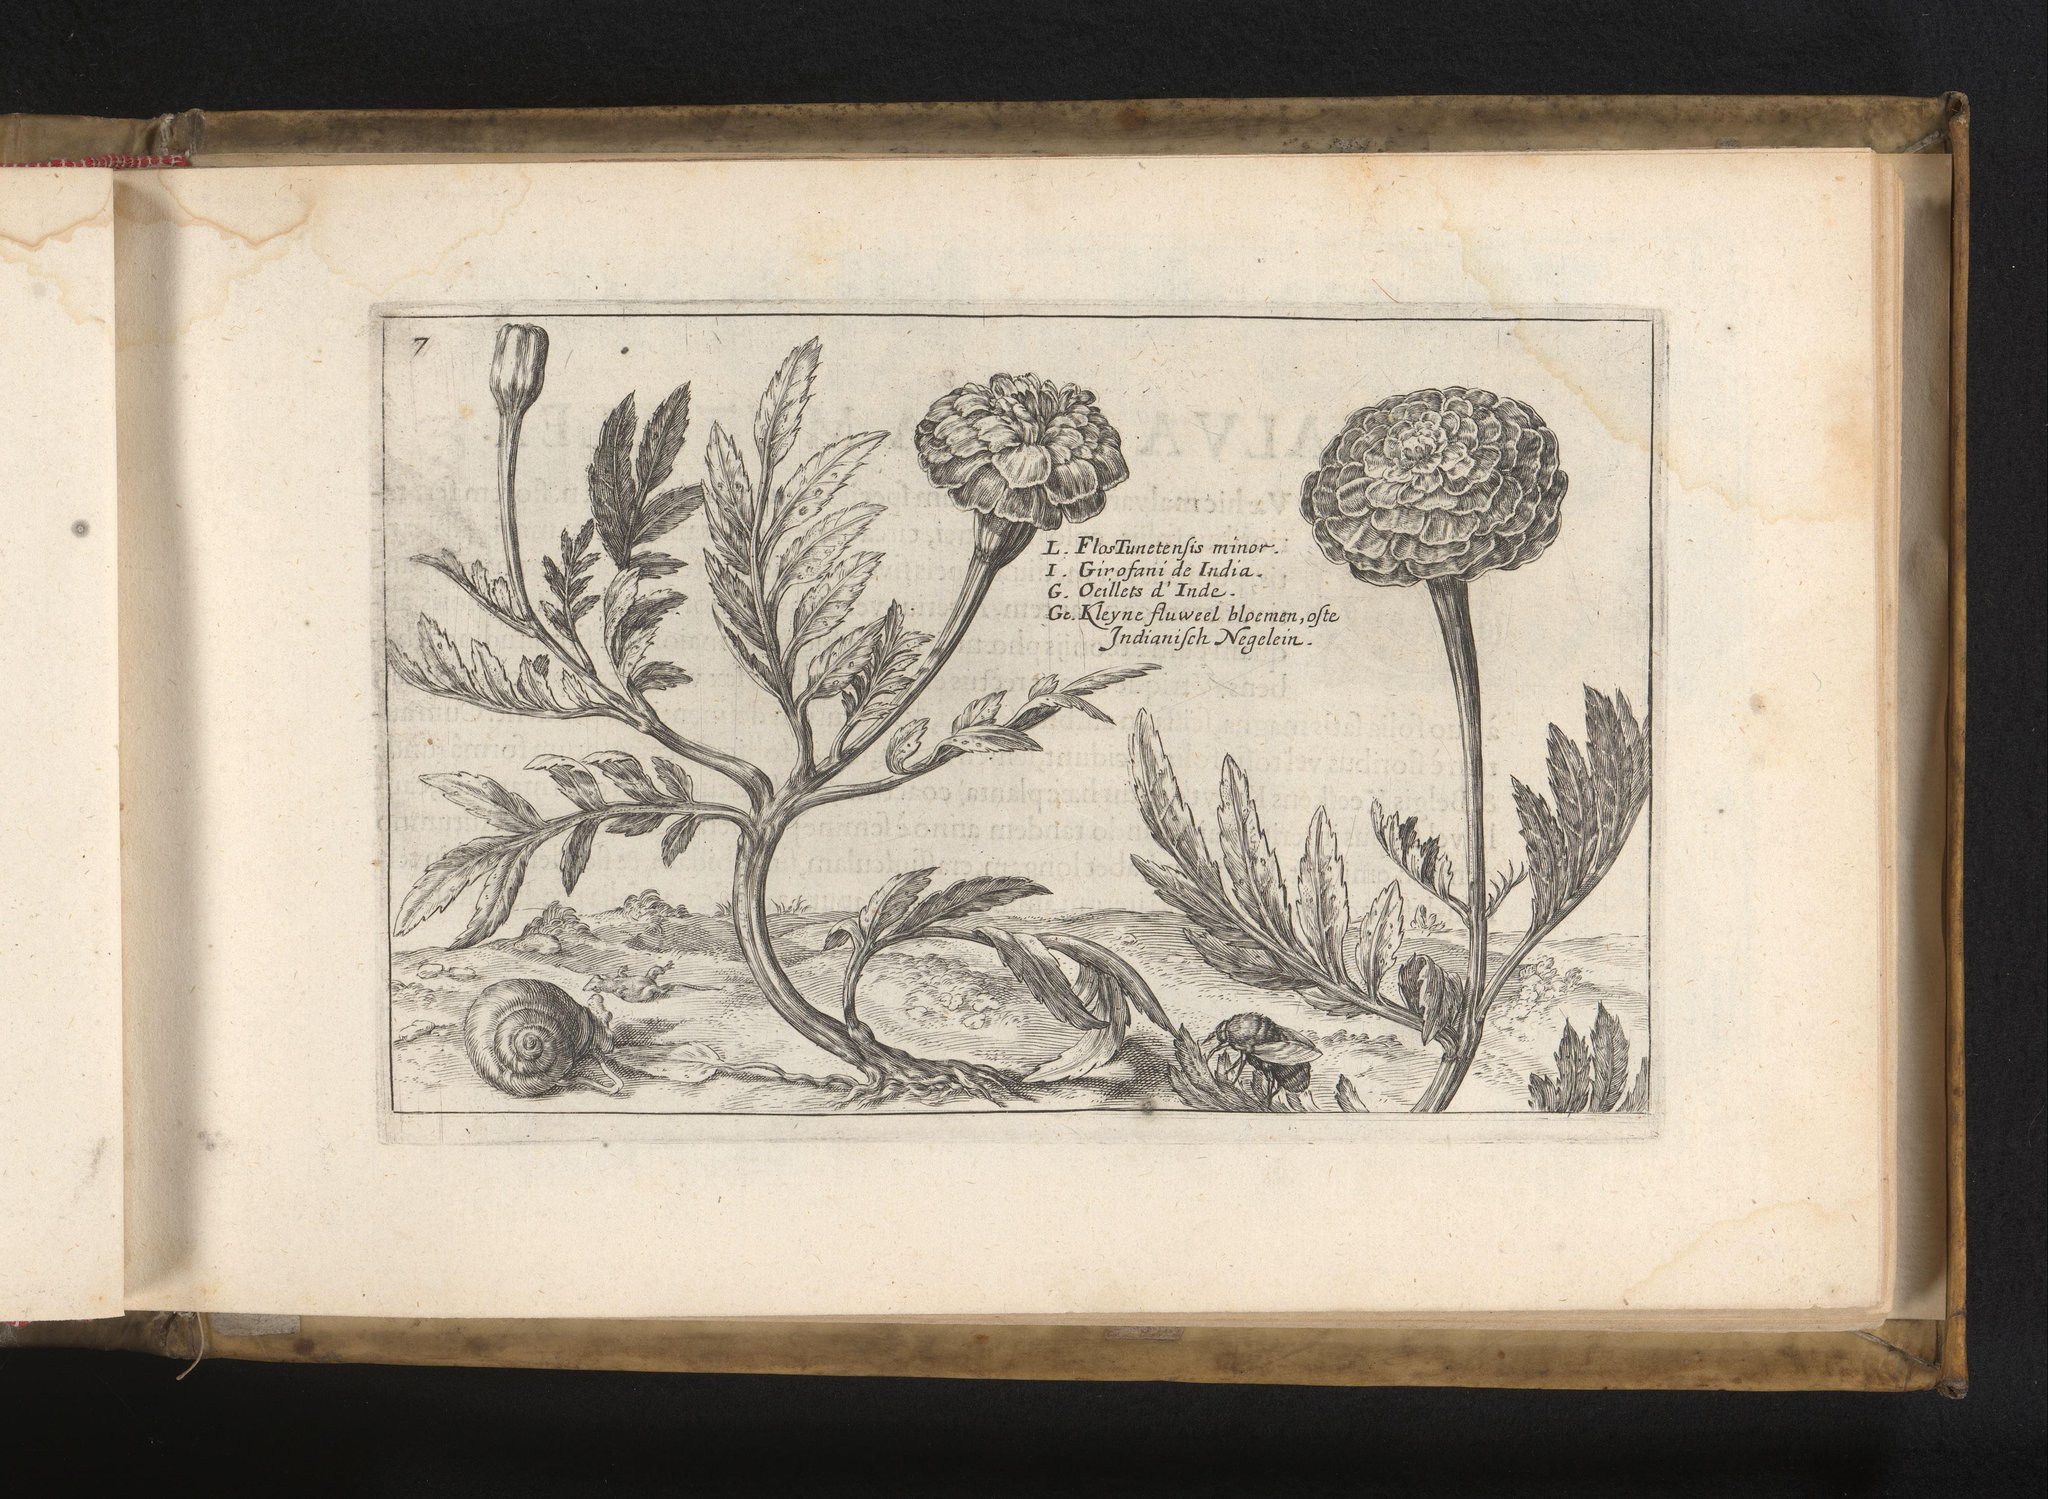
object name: book illustration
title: Bloemtuin van de herfst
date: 1617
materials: paper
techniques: engraving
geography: arnhem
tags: flowers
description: Prent uit: Passe, Crispijn van de (II). Hortus floridus in quo rariorum & minus vulgarium florum icones ad vivam veramque formam. Arnhem: Johannes Janssonius, 1617.